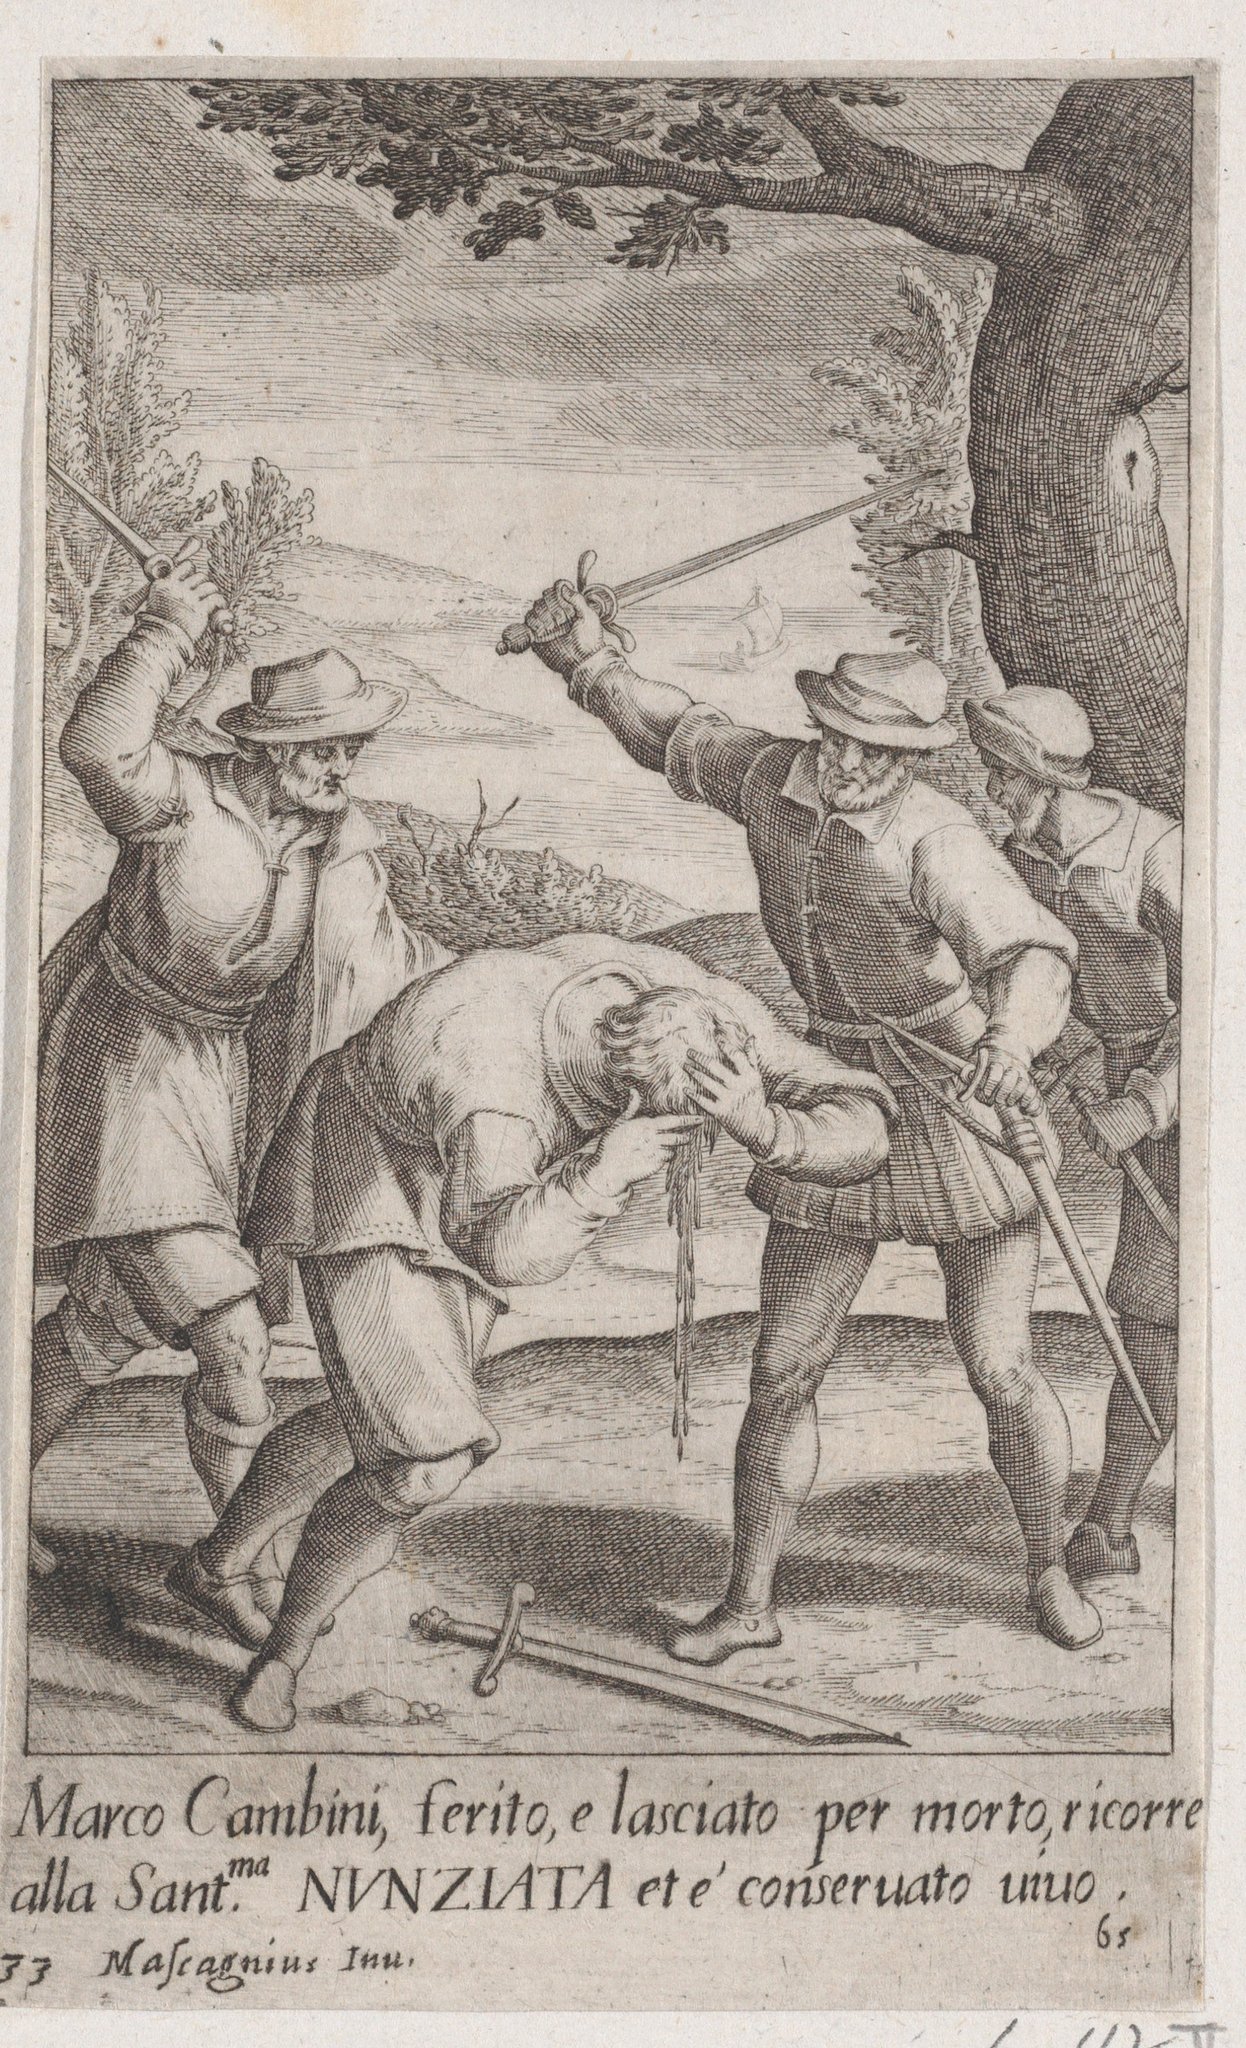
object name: print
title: Marco Cambini, from Scelta d'Alcuni Miracoli e Grazie della Santissima Nunziata di Firenze (Selection of Some Miracles and Graces that Occurred in the Church of the Annunziata in Florence)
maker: jacques callot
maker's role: artist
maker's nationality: french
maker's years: 1592-1635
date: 1611-1619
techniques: engraving